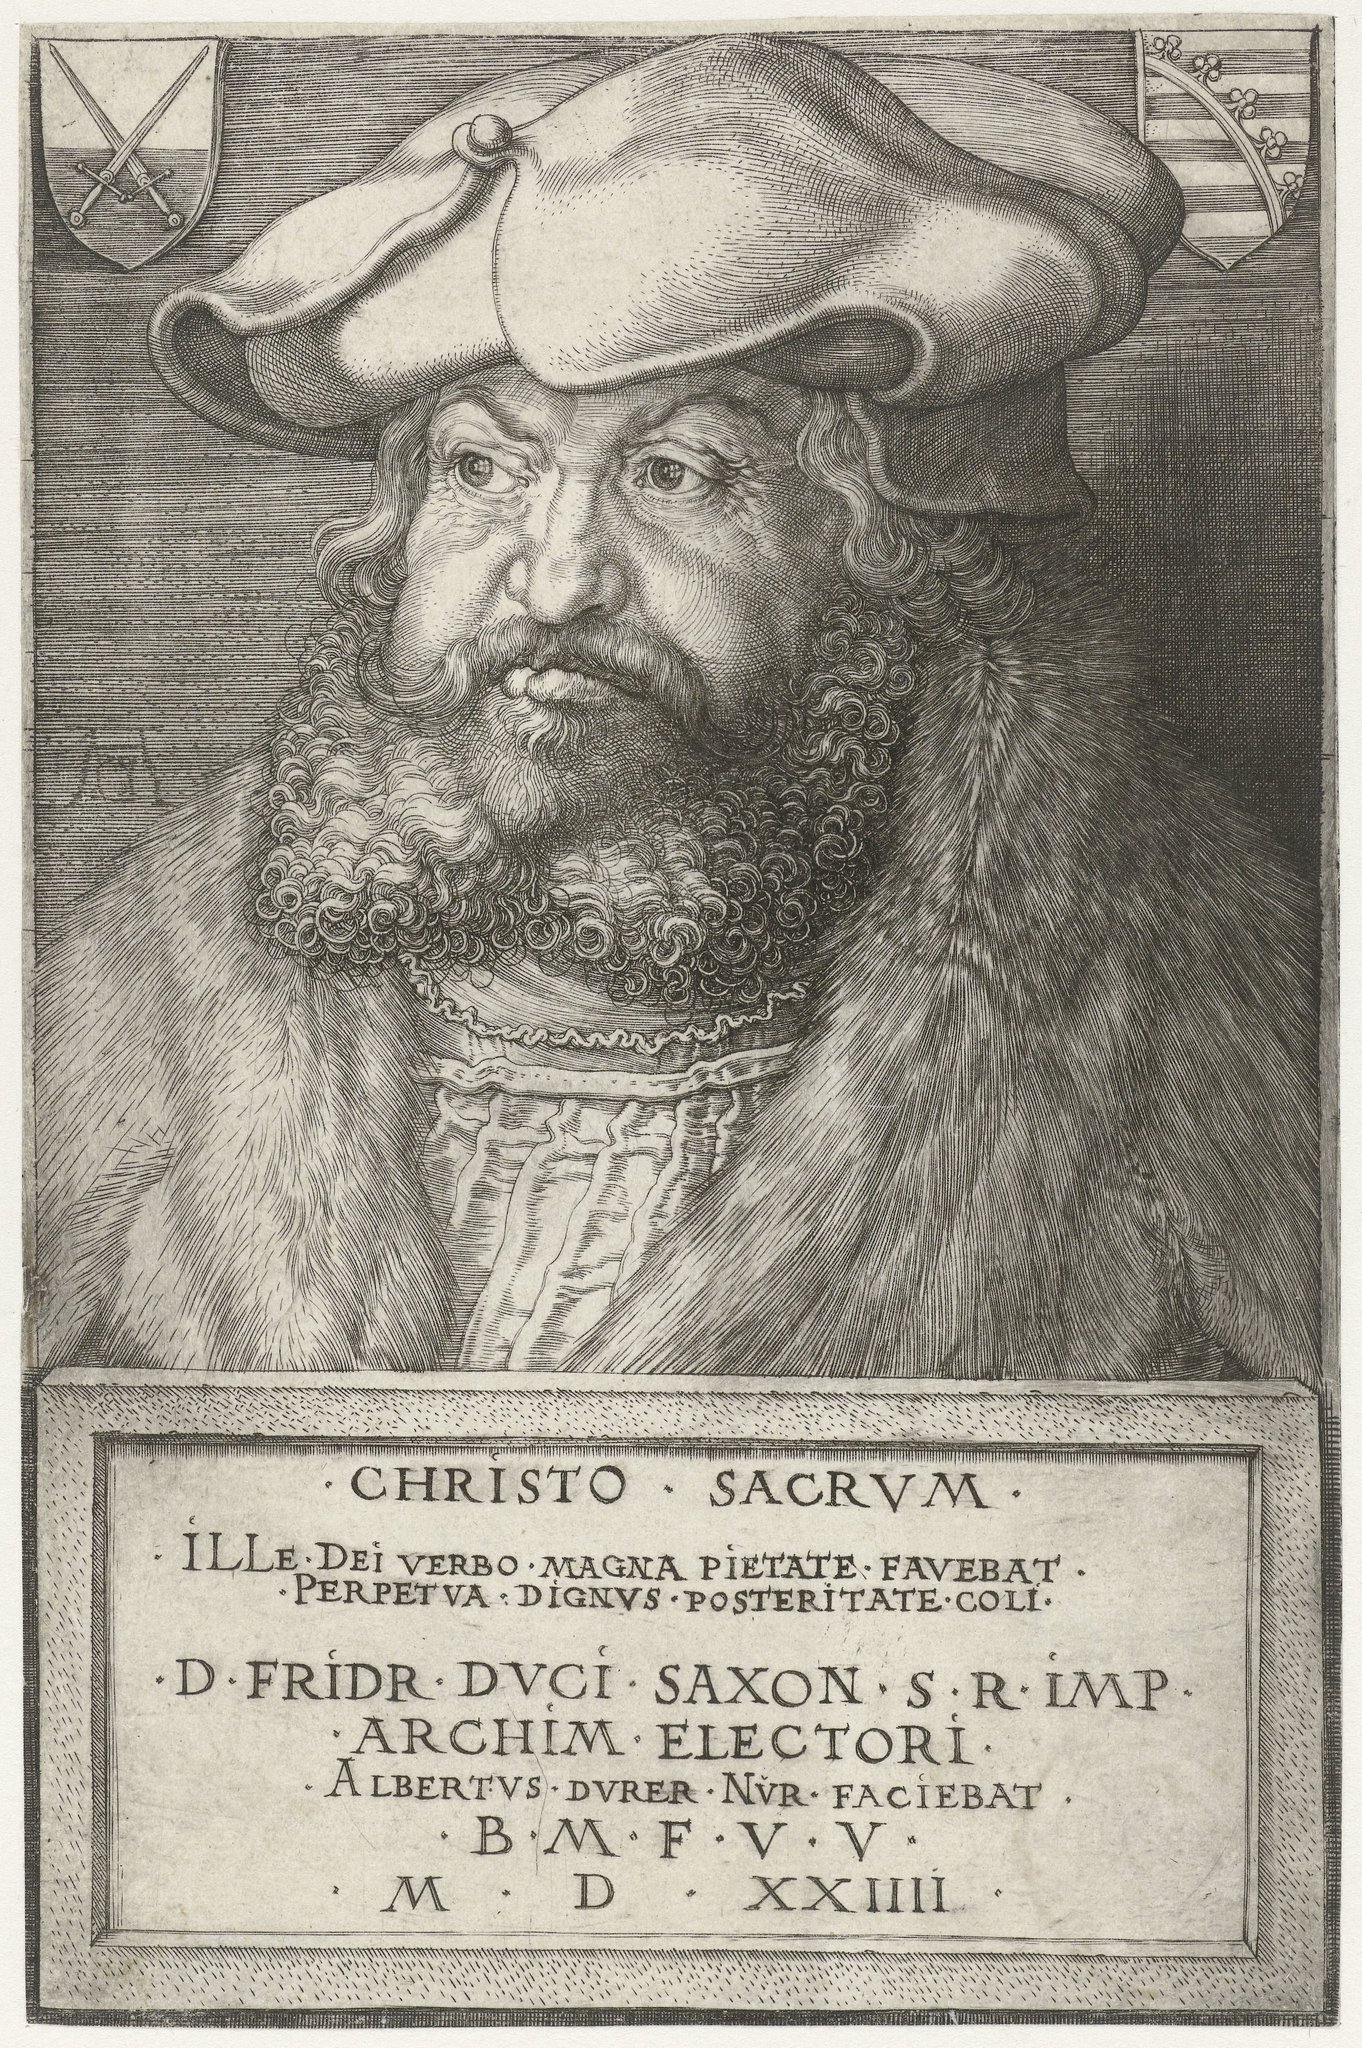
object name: print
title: Portret van Frederik III de Wijze, keurvorst van Saksen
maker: albrecht dürer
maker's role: draughtsman, painter, print maker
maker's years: 1471-1528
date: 1524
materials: paper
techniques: engraving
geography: nuremberg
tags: coat (+ fur used for clothes), coat (+ men's clothes), head-gear: cap (+ men's clothes), historical persons, clothing for the upper part of the body (+ men's clothes), beard, armorial bearing, heraldry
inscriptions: collector's mark: Lugt 240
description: Portret van Frederik III de Wijze, keurvorst van Saksen. Ronde bonnet* met omhooggeslagen en vastgeknoopte oorlappen*, tabbaard* met bontkraag, aangerimpeld hemd*. Hij heeft een gespleten krulbaard* en een snor*. Kleding 1520-1530.